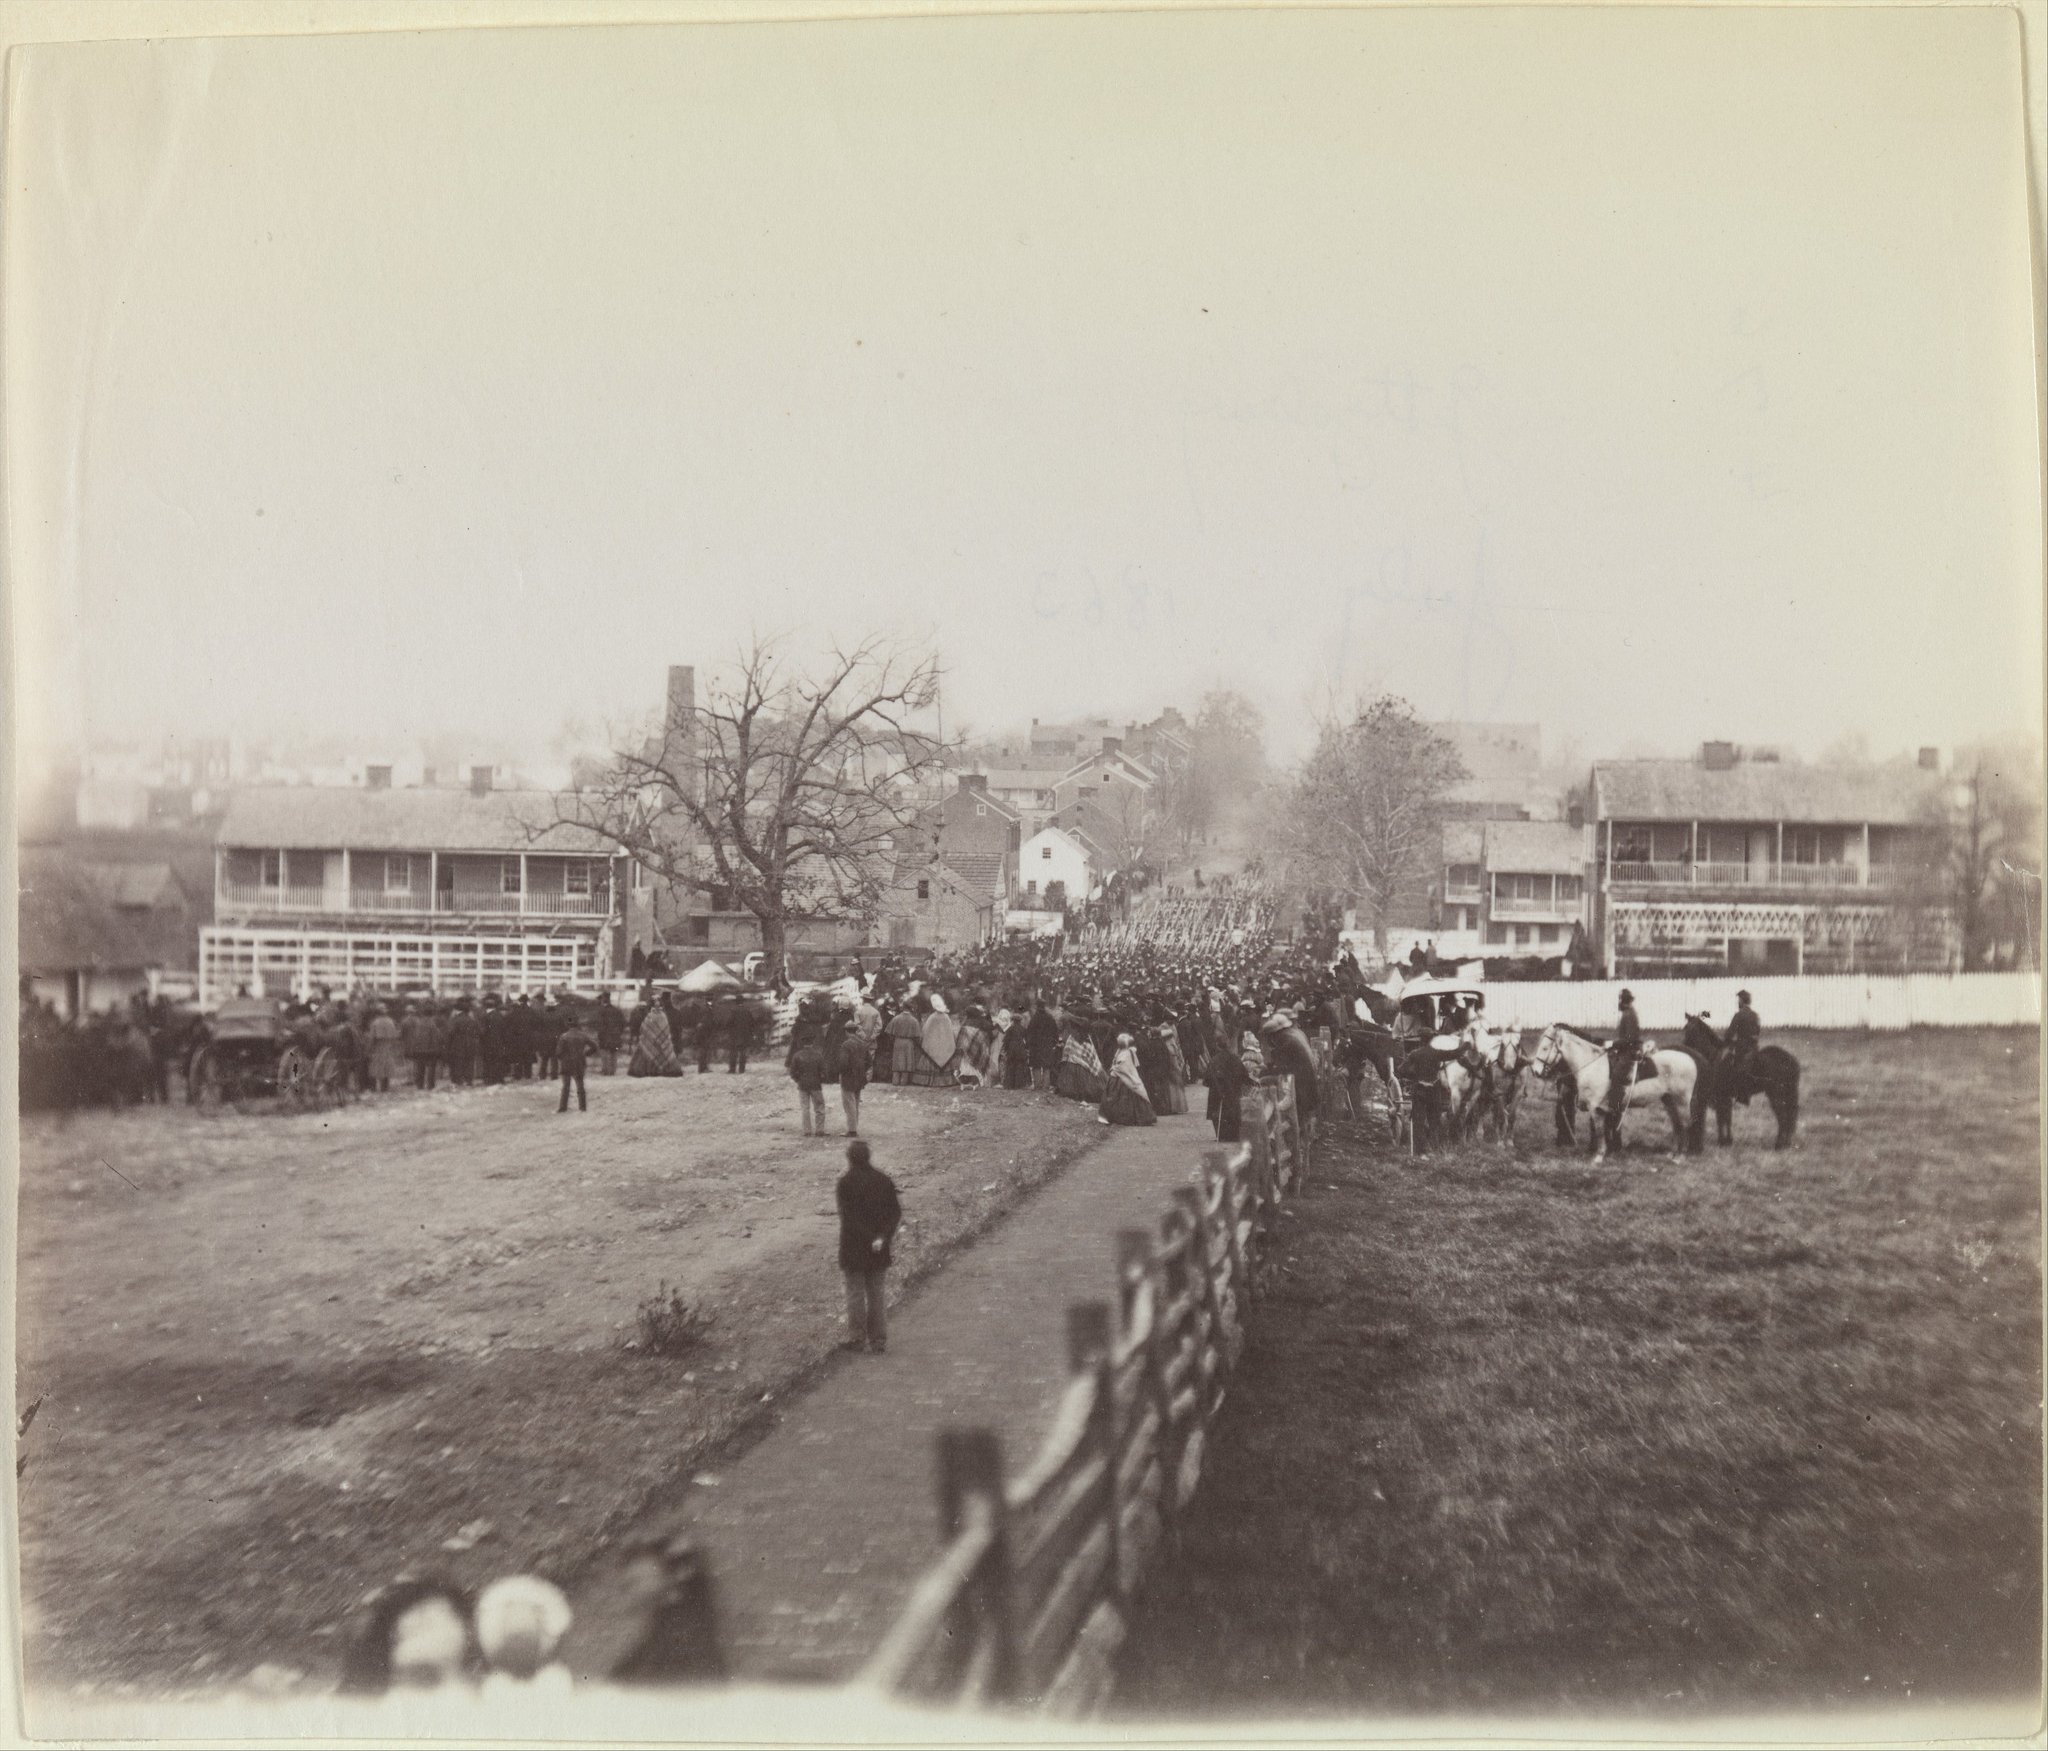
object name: photograph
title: Procession of Troops and Civilians on Way to Dedication of Soldiers' National Cemetery, Gettysburg, Pennsylvania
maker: isaac g. tyson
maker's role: artist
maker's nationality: american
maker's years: 1833-1913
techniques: albumen silver print, glass negative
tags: soldiers,american civil war,horses,crowd